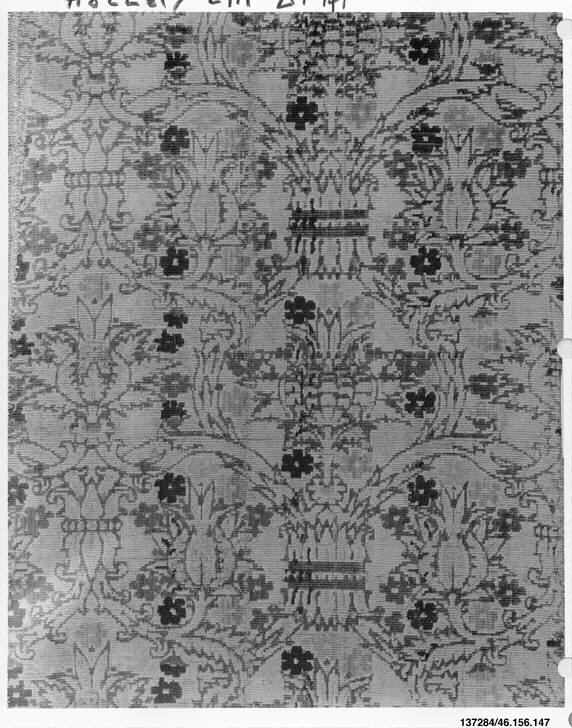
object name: piece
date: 1500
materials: metal thread, silk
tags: flowers